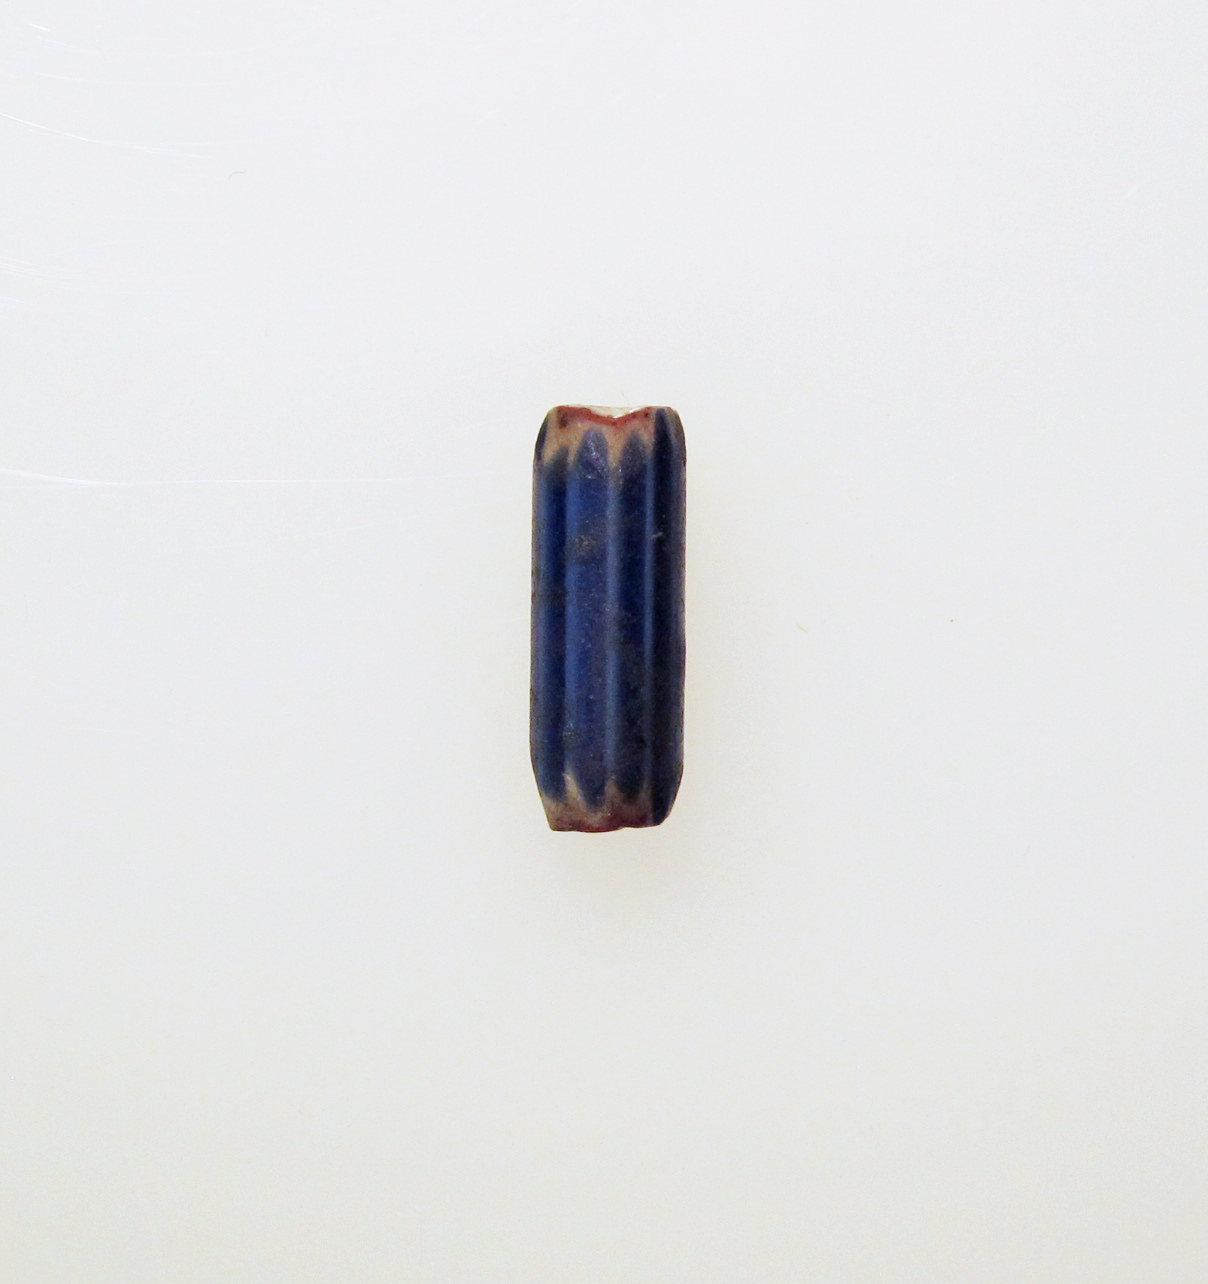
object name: bead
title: Glass bead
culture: venetian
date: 900-100 BCE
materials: glass